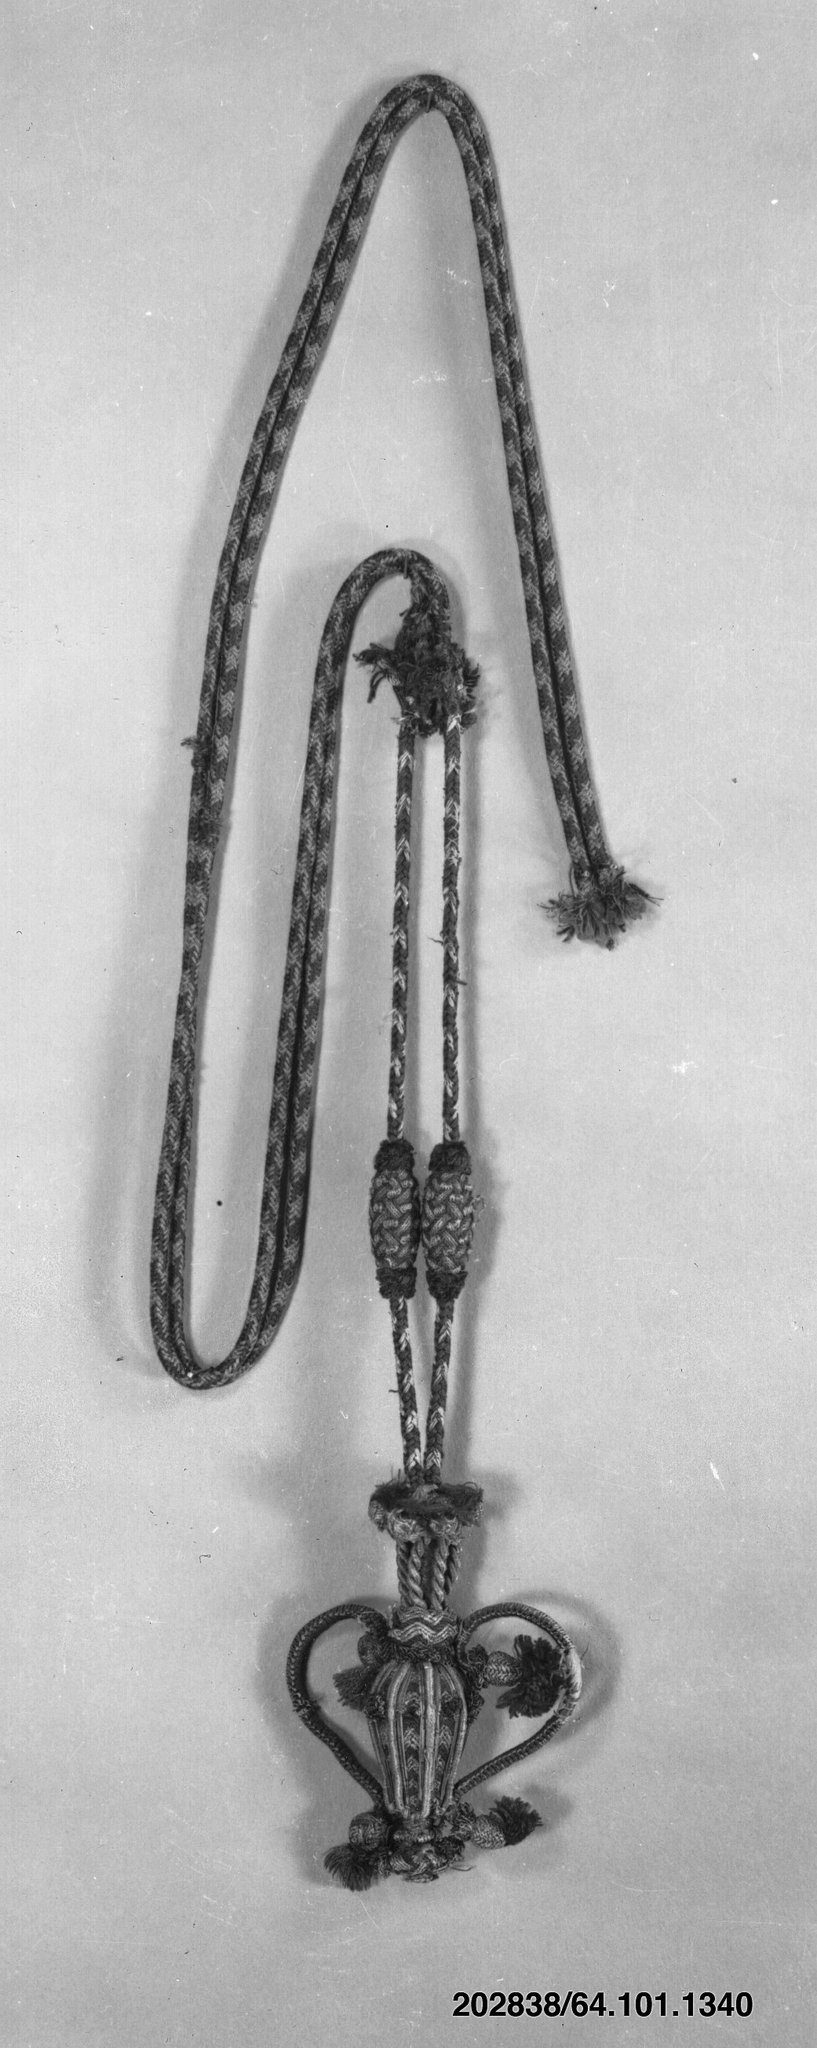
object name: bell pull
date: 1601-1700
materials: silk